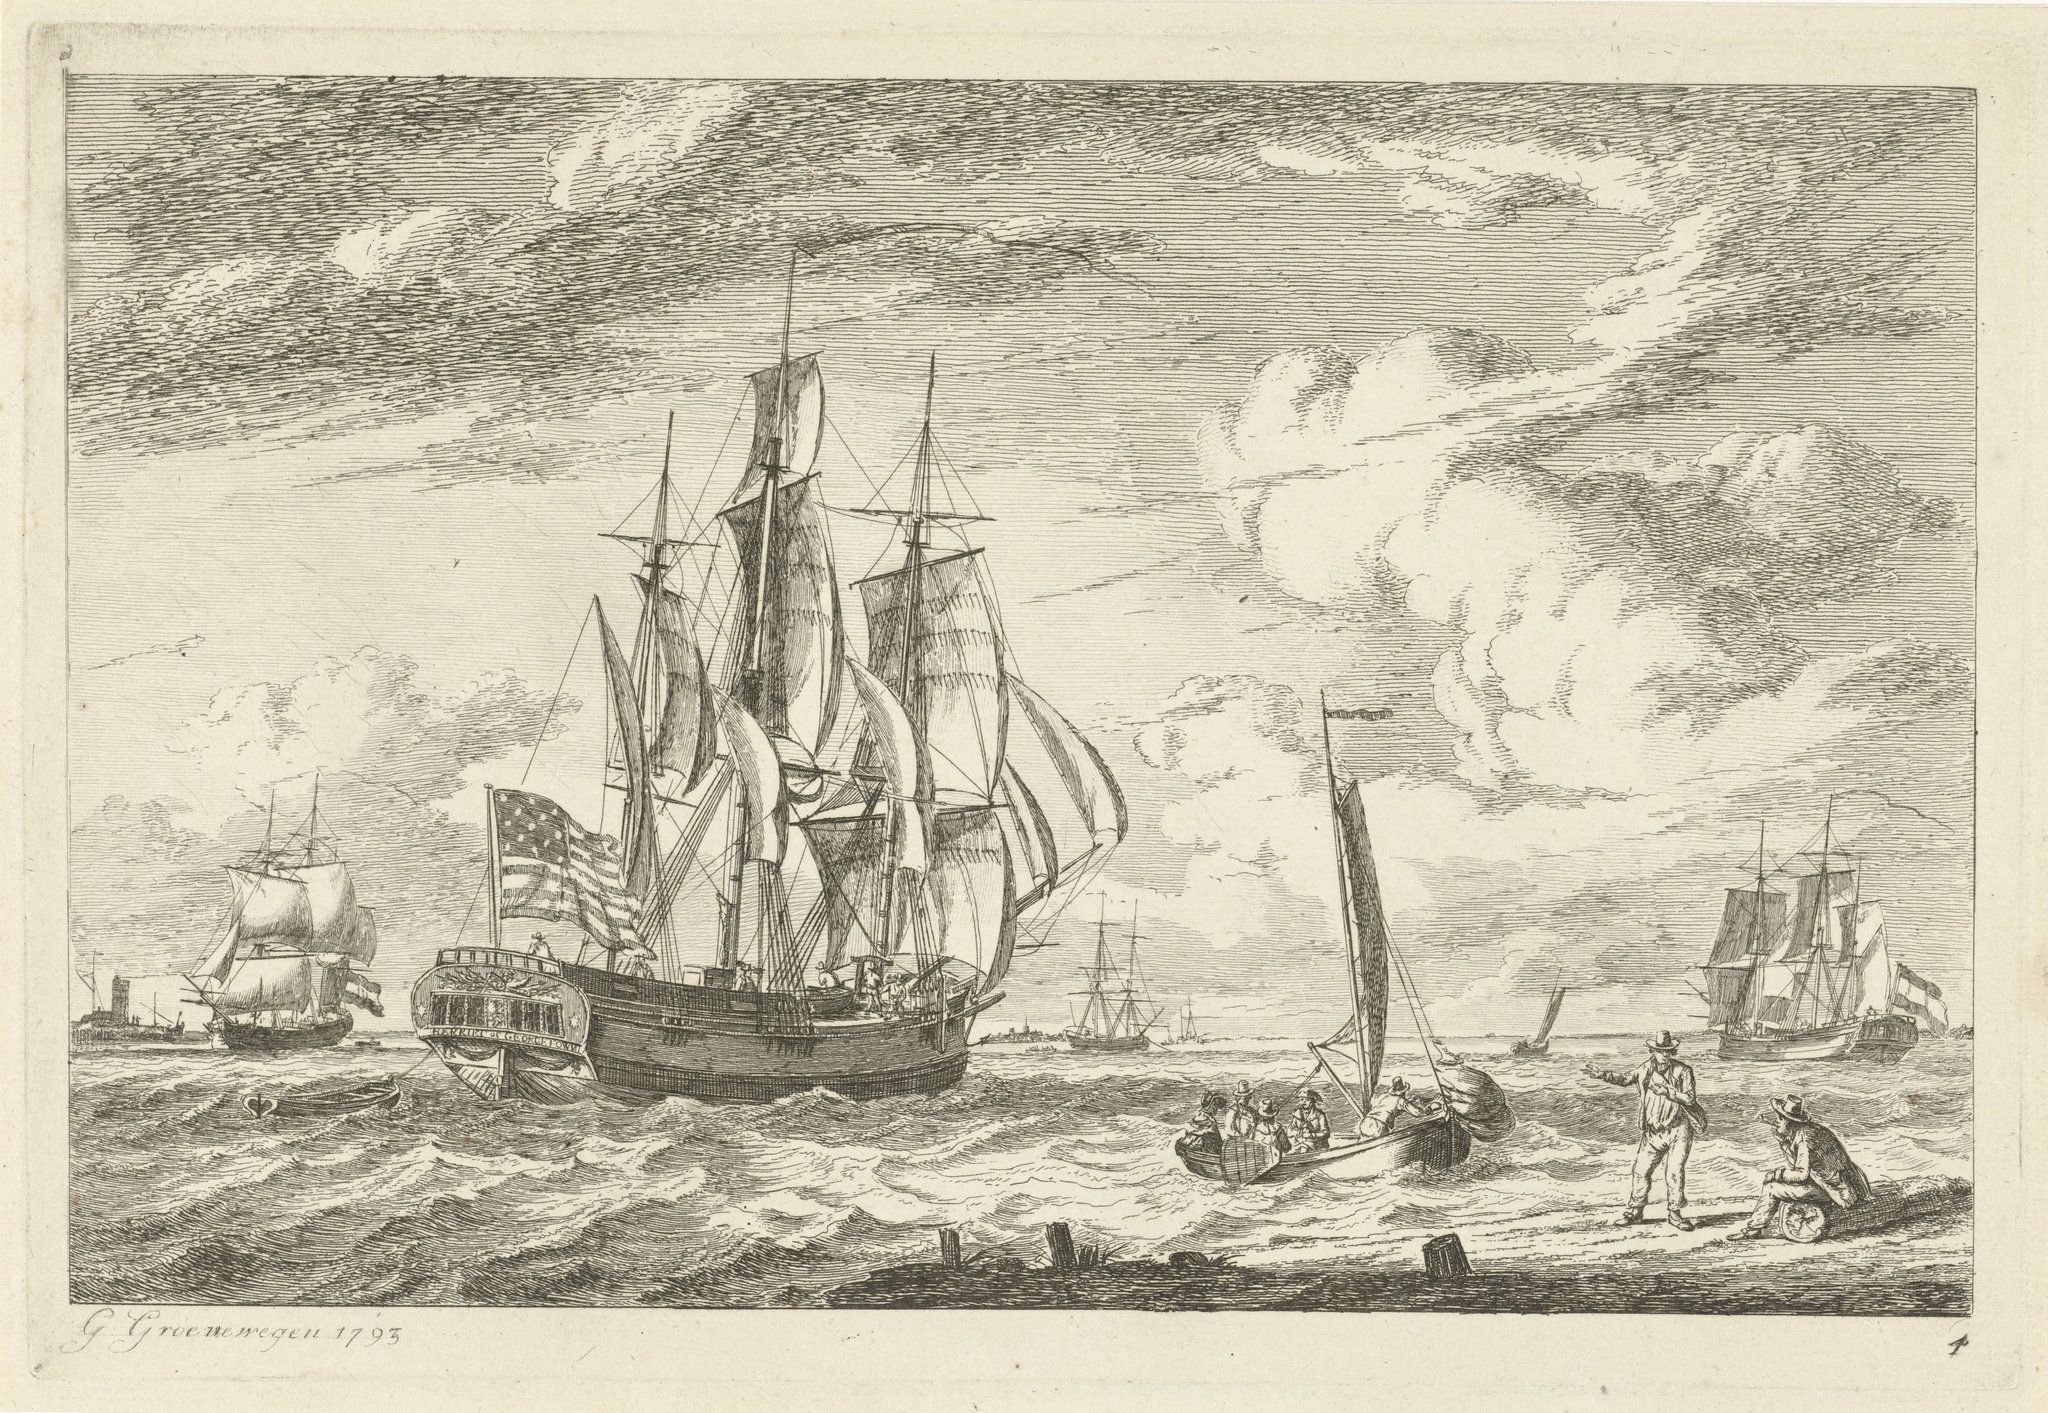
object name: print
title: Amerikaanse driemaster en andere schepen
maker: gerrit groenewegen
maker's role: draughtsman, print maker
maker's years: 1754-1826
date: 1793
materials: paper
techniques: engraving, etching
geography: rotterdam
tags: ships (in general)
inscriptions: collector's mark: Lugt 2228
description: Een Amerikaanse driemaster en andere schepen op woelig water. De naam van het Amerikaanse schip staat op de spiegel 'Harriet of Georgetown'. Op het schip staan zes figuren. Rechts op de voorgrond zijn twee mannen aan wal afgebeeld, waarvan er één een pijp zit te roken. Op de achtergrond de contouren van diverse zeilschepen en bebouwing. Deze prent maakt deel uit van een serie van vijf prenten met verschillende schepen op open water. Rechts in de marge: 4.